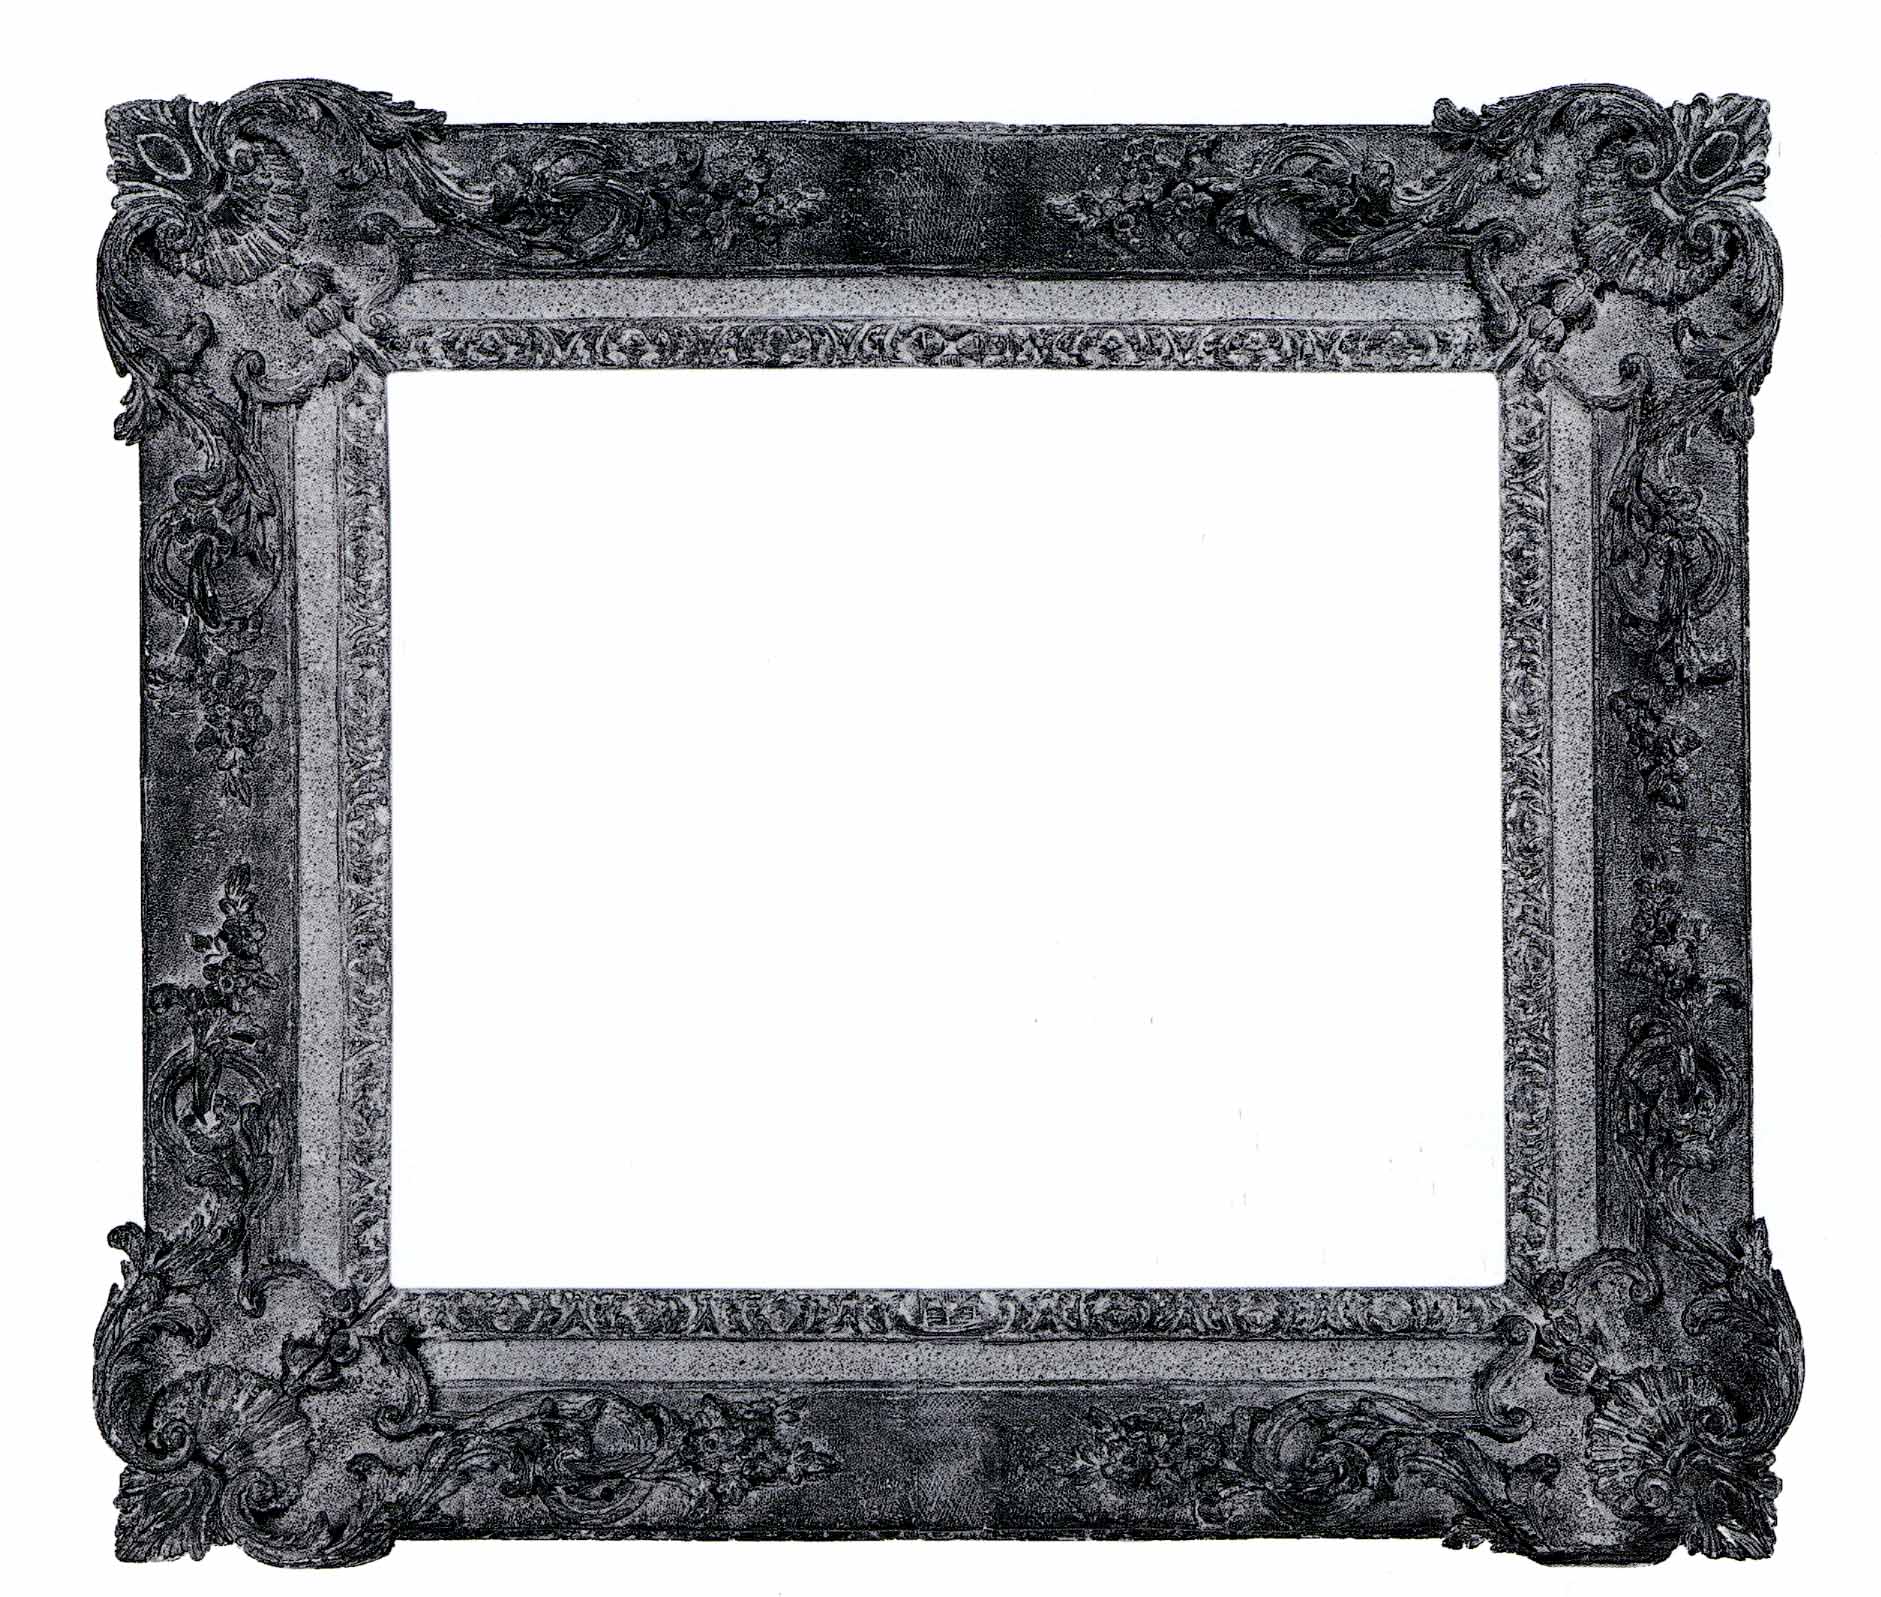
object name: frame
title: Louis XIV-style frame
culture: british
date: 1720-1730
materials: gilt, wood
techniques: carving